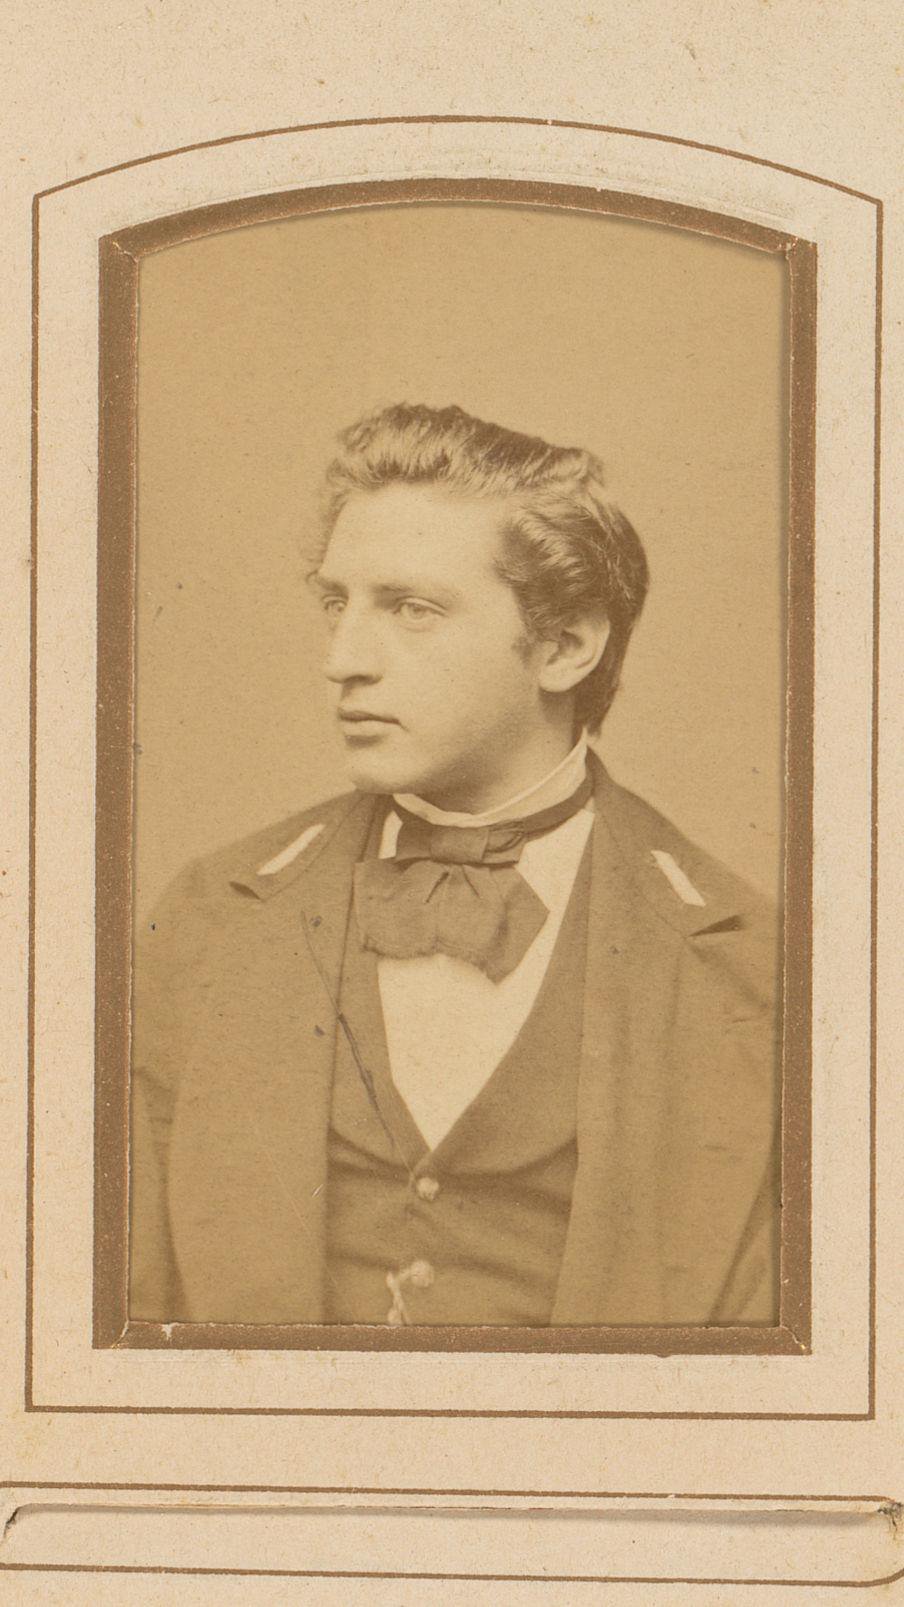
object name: photograph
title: Portret van Johan Hendrik Beucker Andreae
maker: Anonymous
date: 1870-1885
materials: cardboard, paper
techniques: albumen print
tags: the hague, adult man, historical persons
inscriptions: inscription: ‘J.H. Beucker Andreae./ Kapitein ter Zee 1850-1933.’